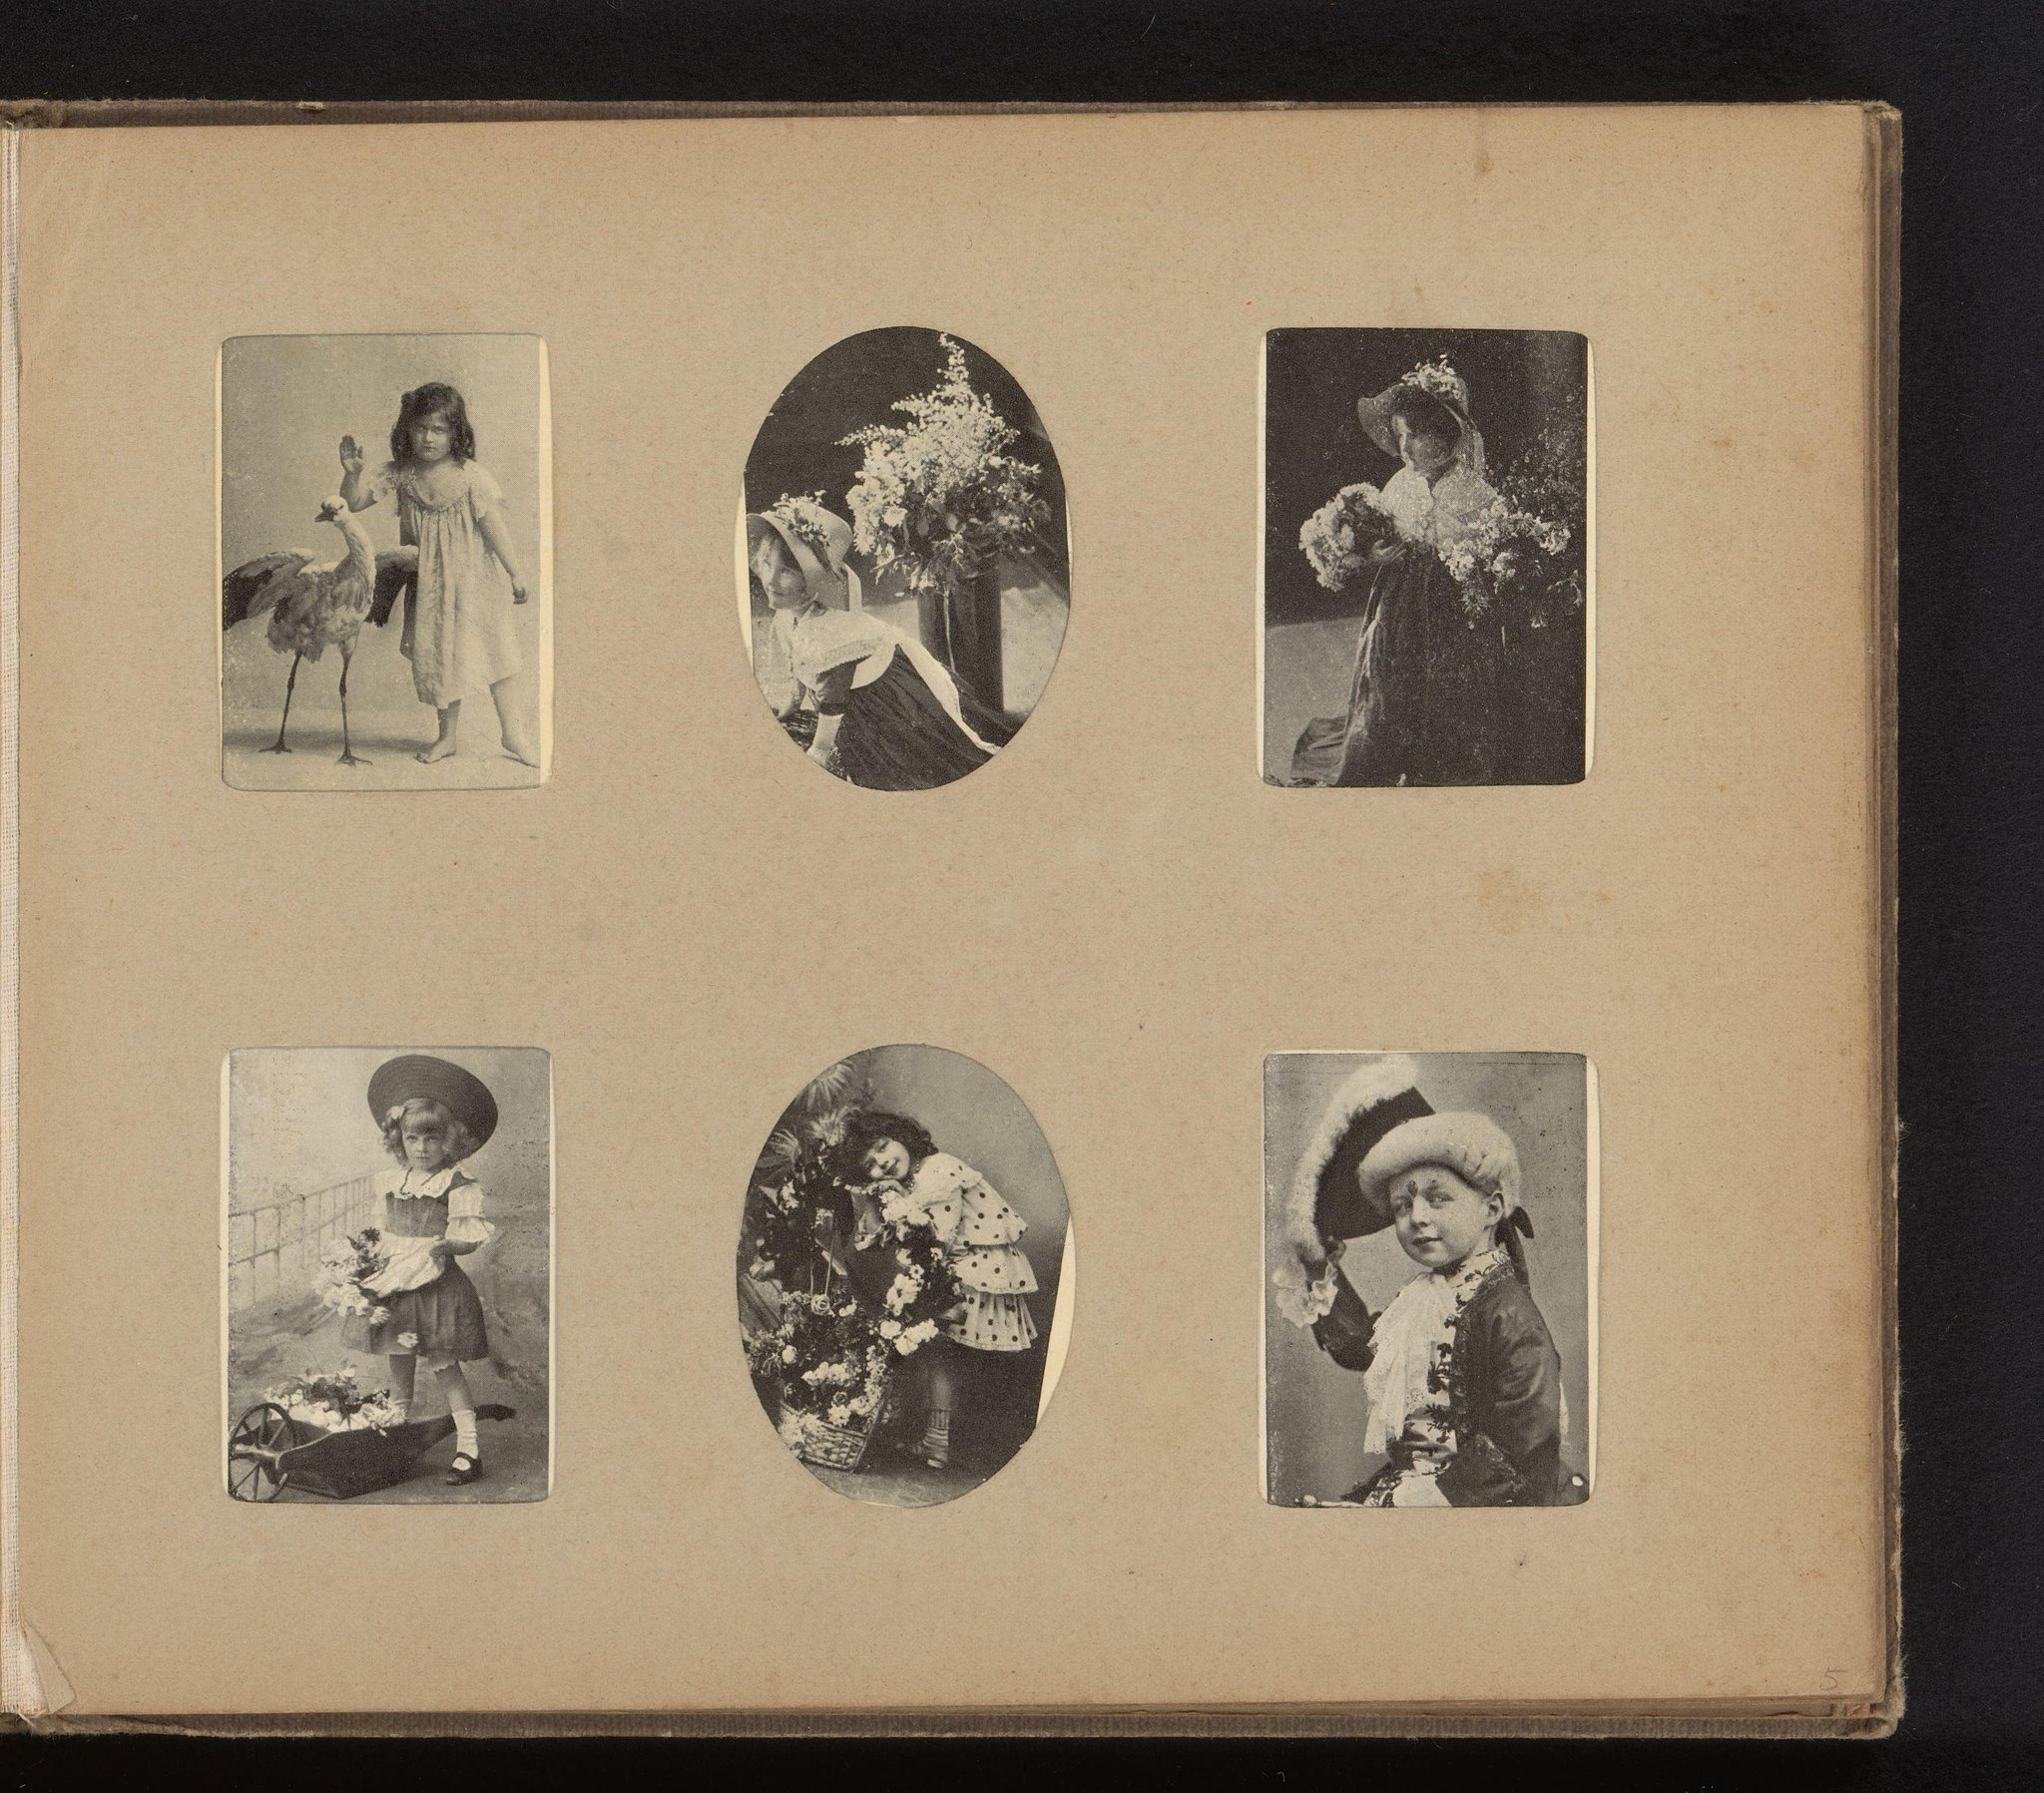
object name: photomechanical print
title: Kinderportretten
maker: Anonymous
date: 1890-1900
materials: cardboard, paper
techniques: autotype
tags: shore-birds and wading-birds: stork, clothes, costume, child (at home)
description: Zes portretten van kinderen, waaronder één van een meisje met een ooievaar en één van een jongen in kostuum met pruik. Deze pagina is deel van een album.